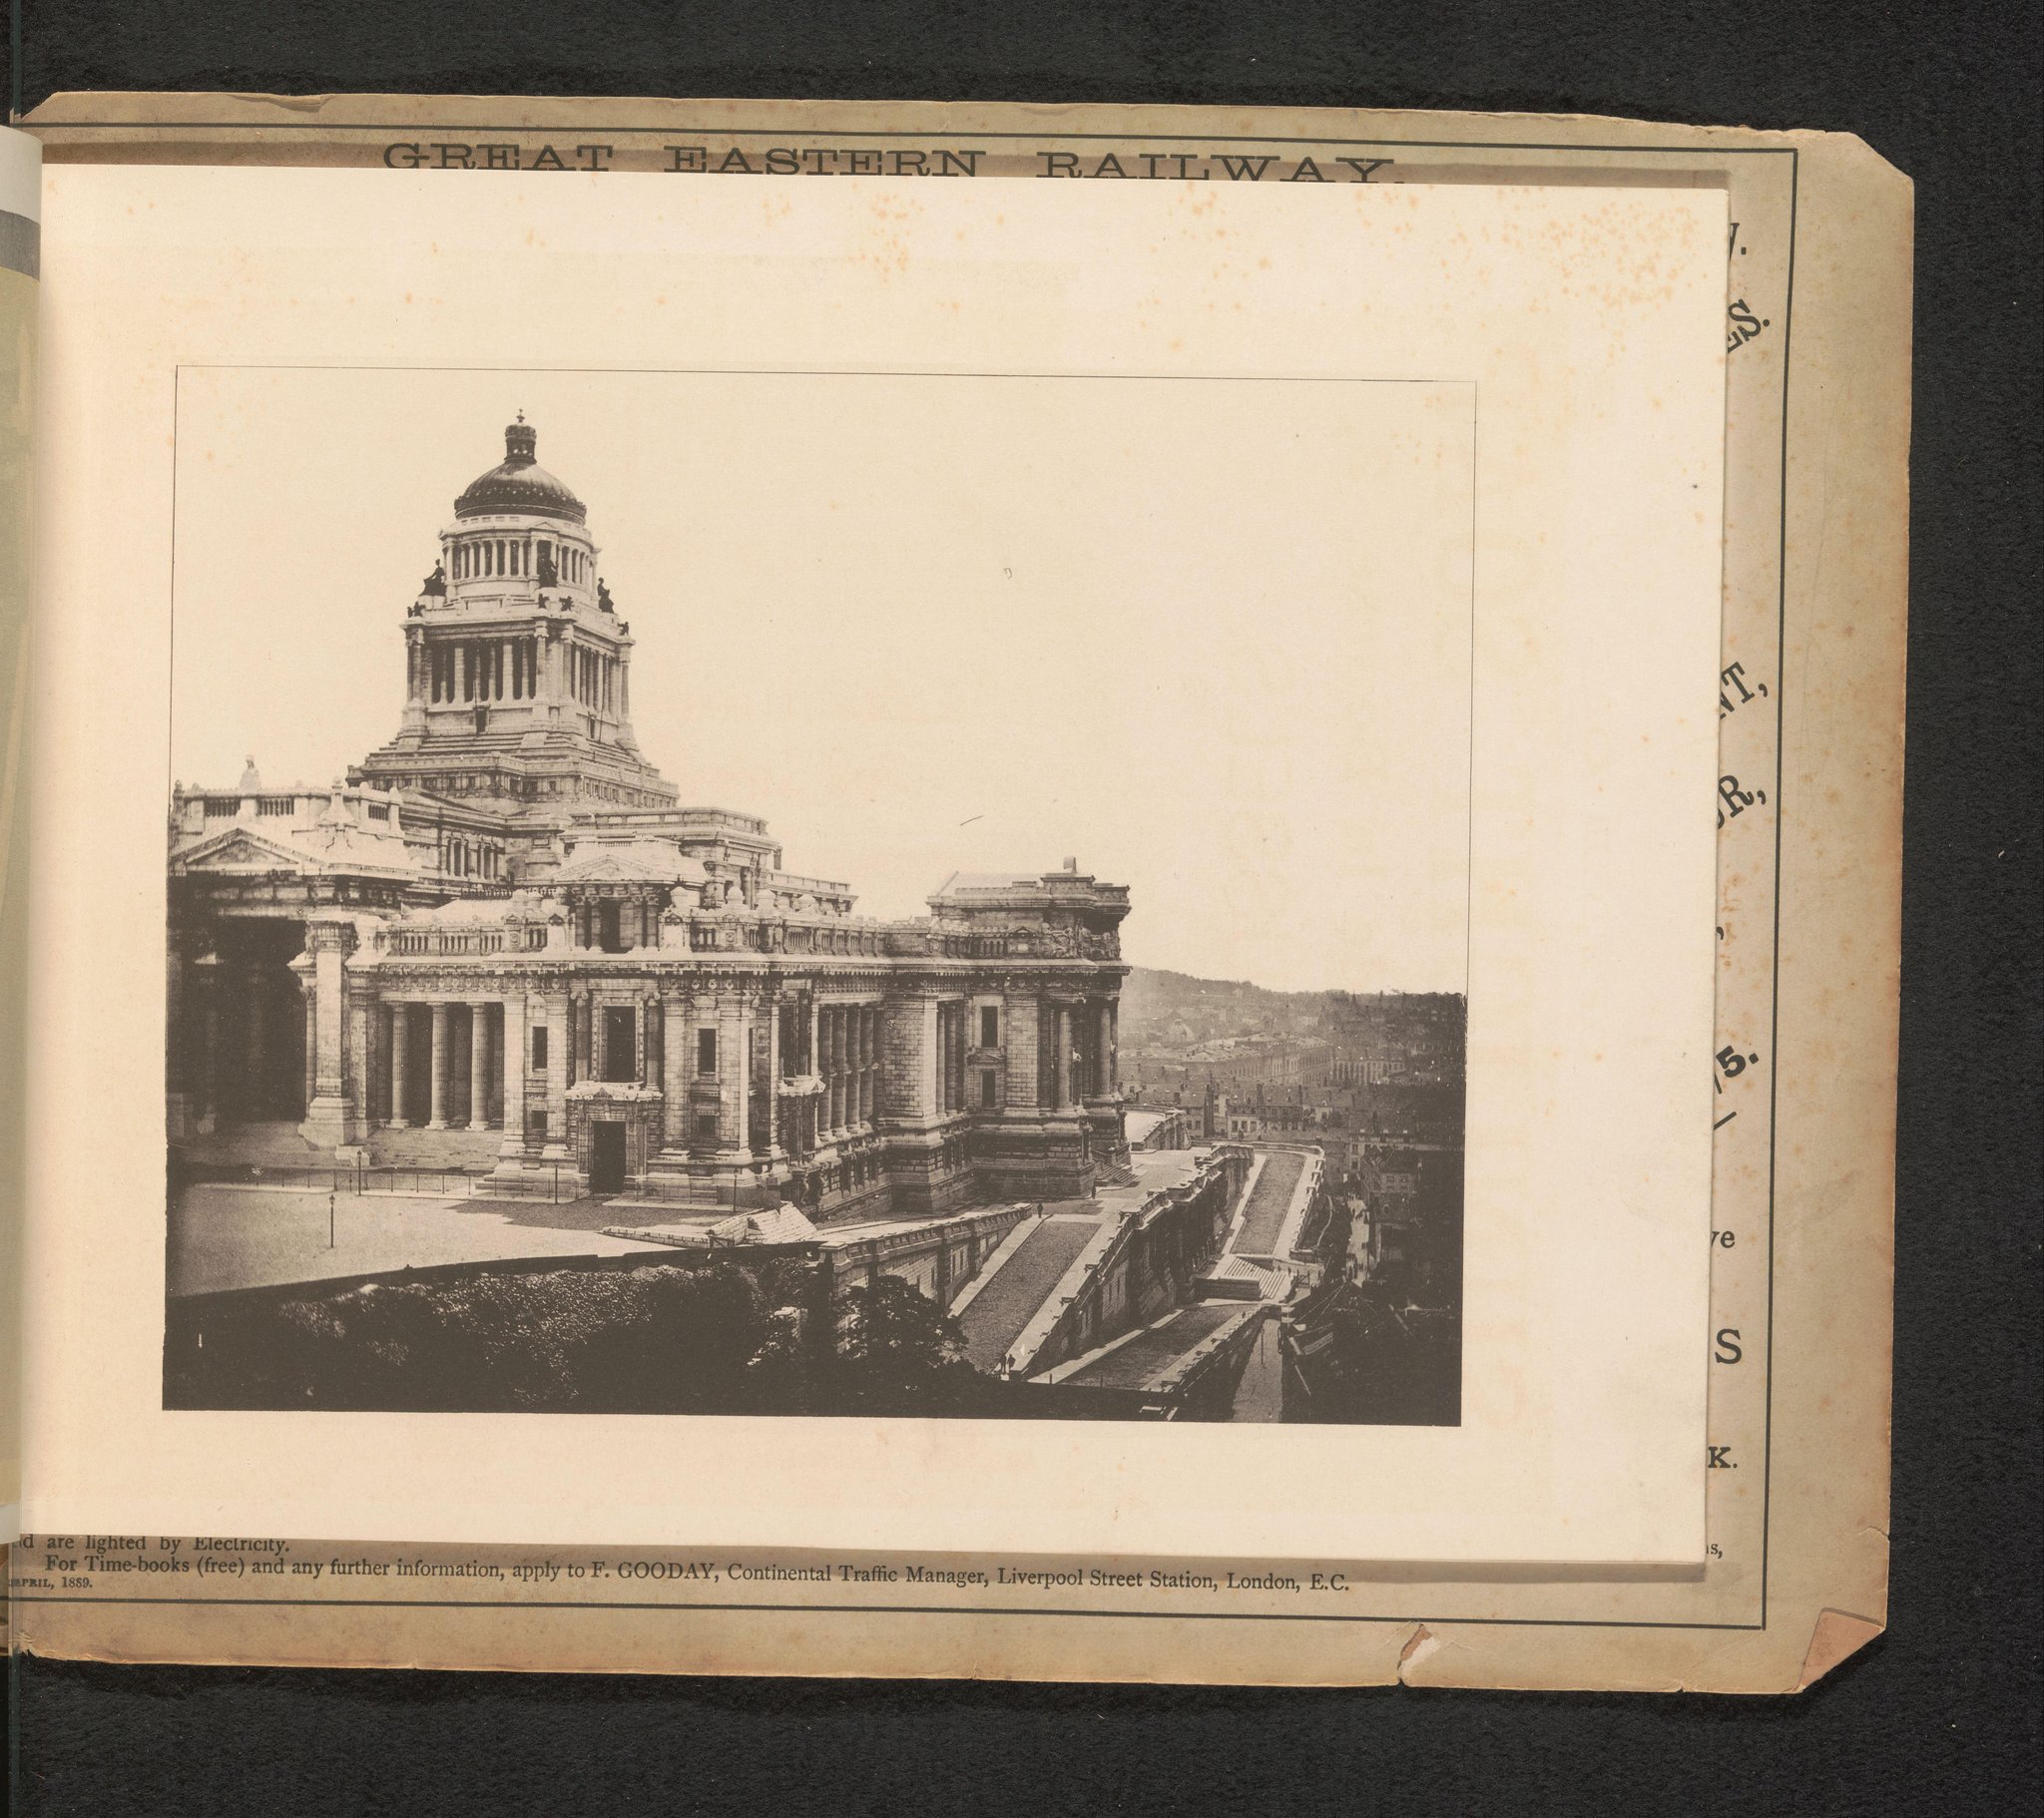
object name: page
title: Gezicht op het Paleis van Justitie in Brussel, België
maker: Anonymous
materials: paper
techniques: photograph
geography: brussels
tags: court building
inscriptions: number: ‘1’